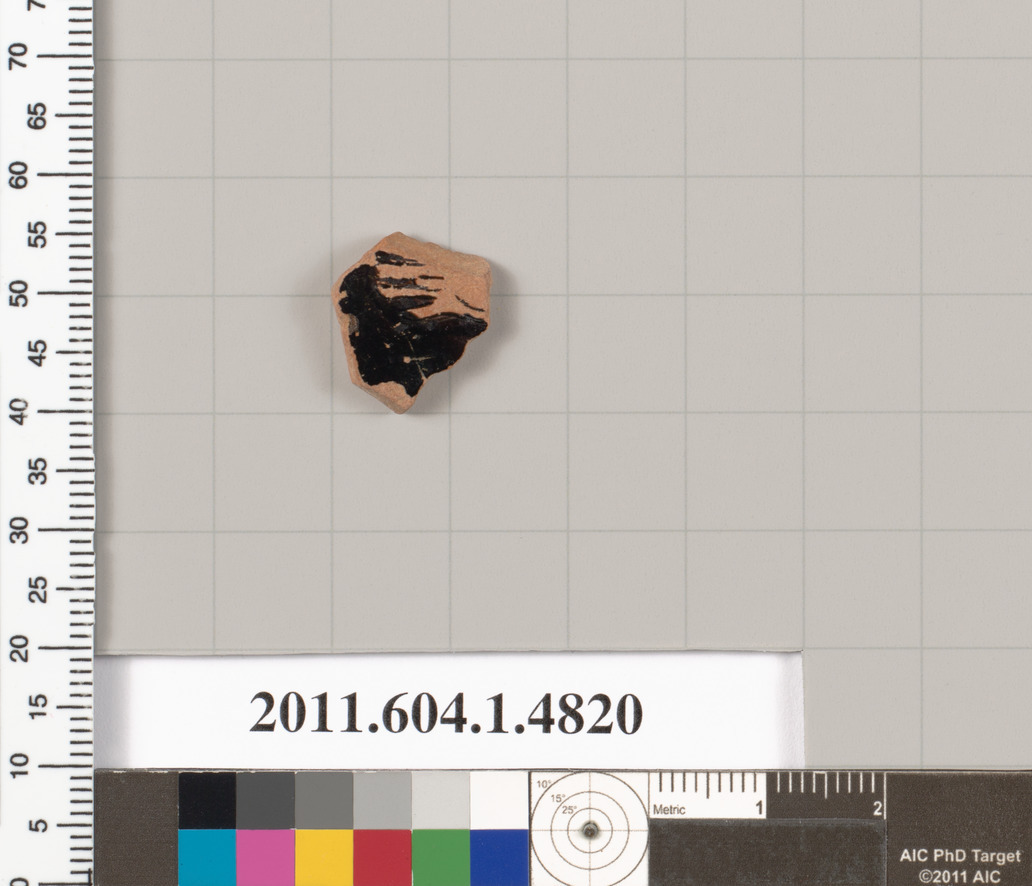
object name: kylix fragment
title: Terracotta fragment of a kylix (drinking cup)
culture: greek, attic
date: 500-480 BCE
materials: terracotta